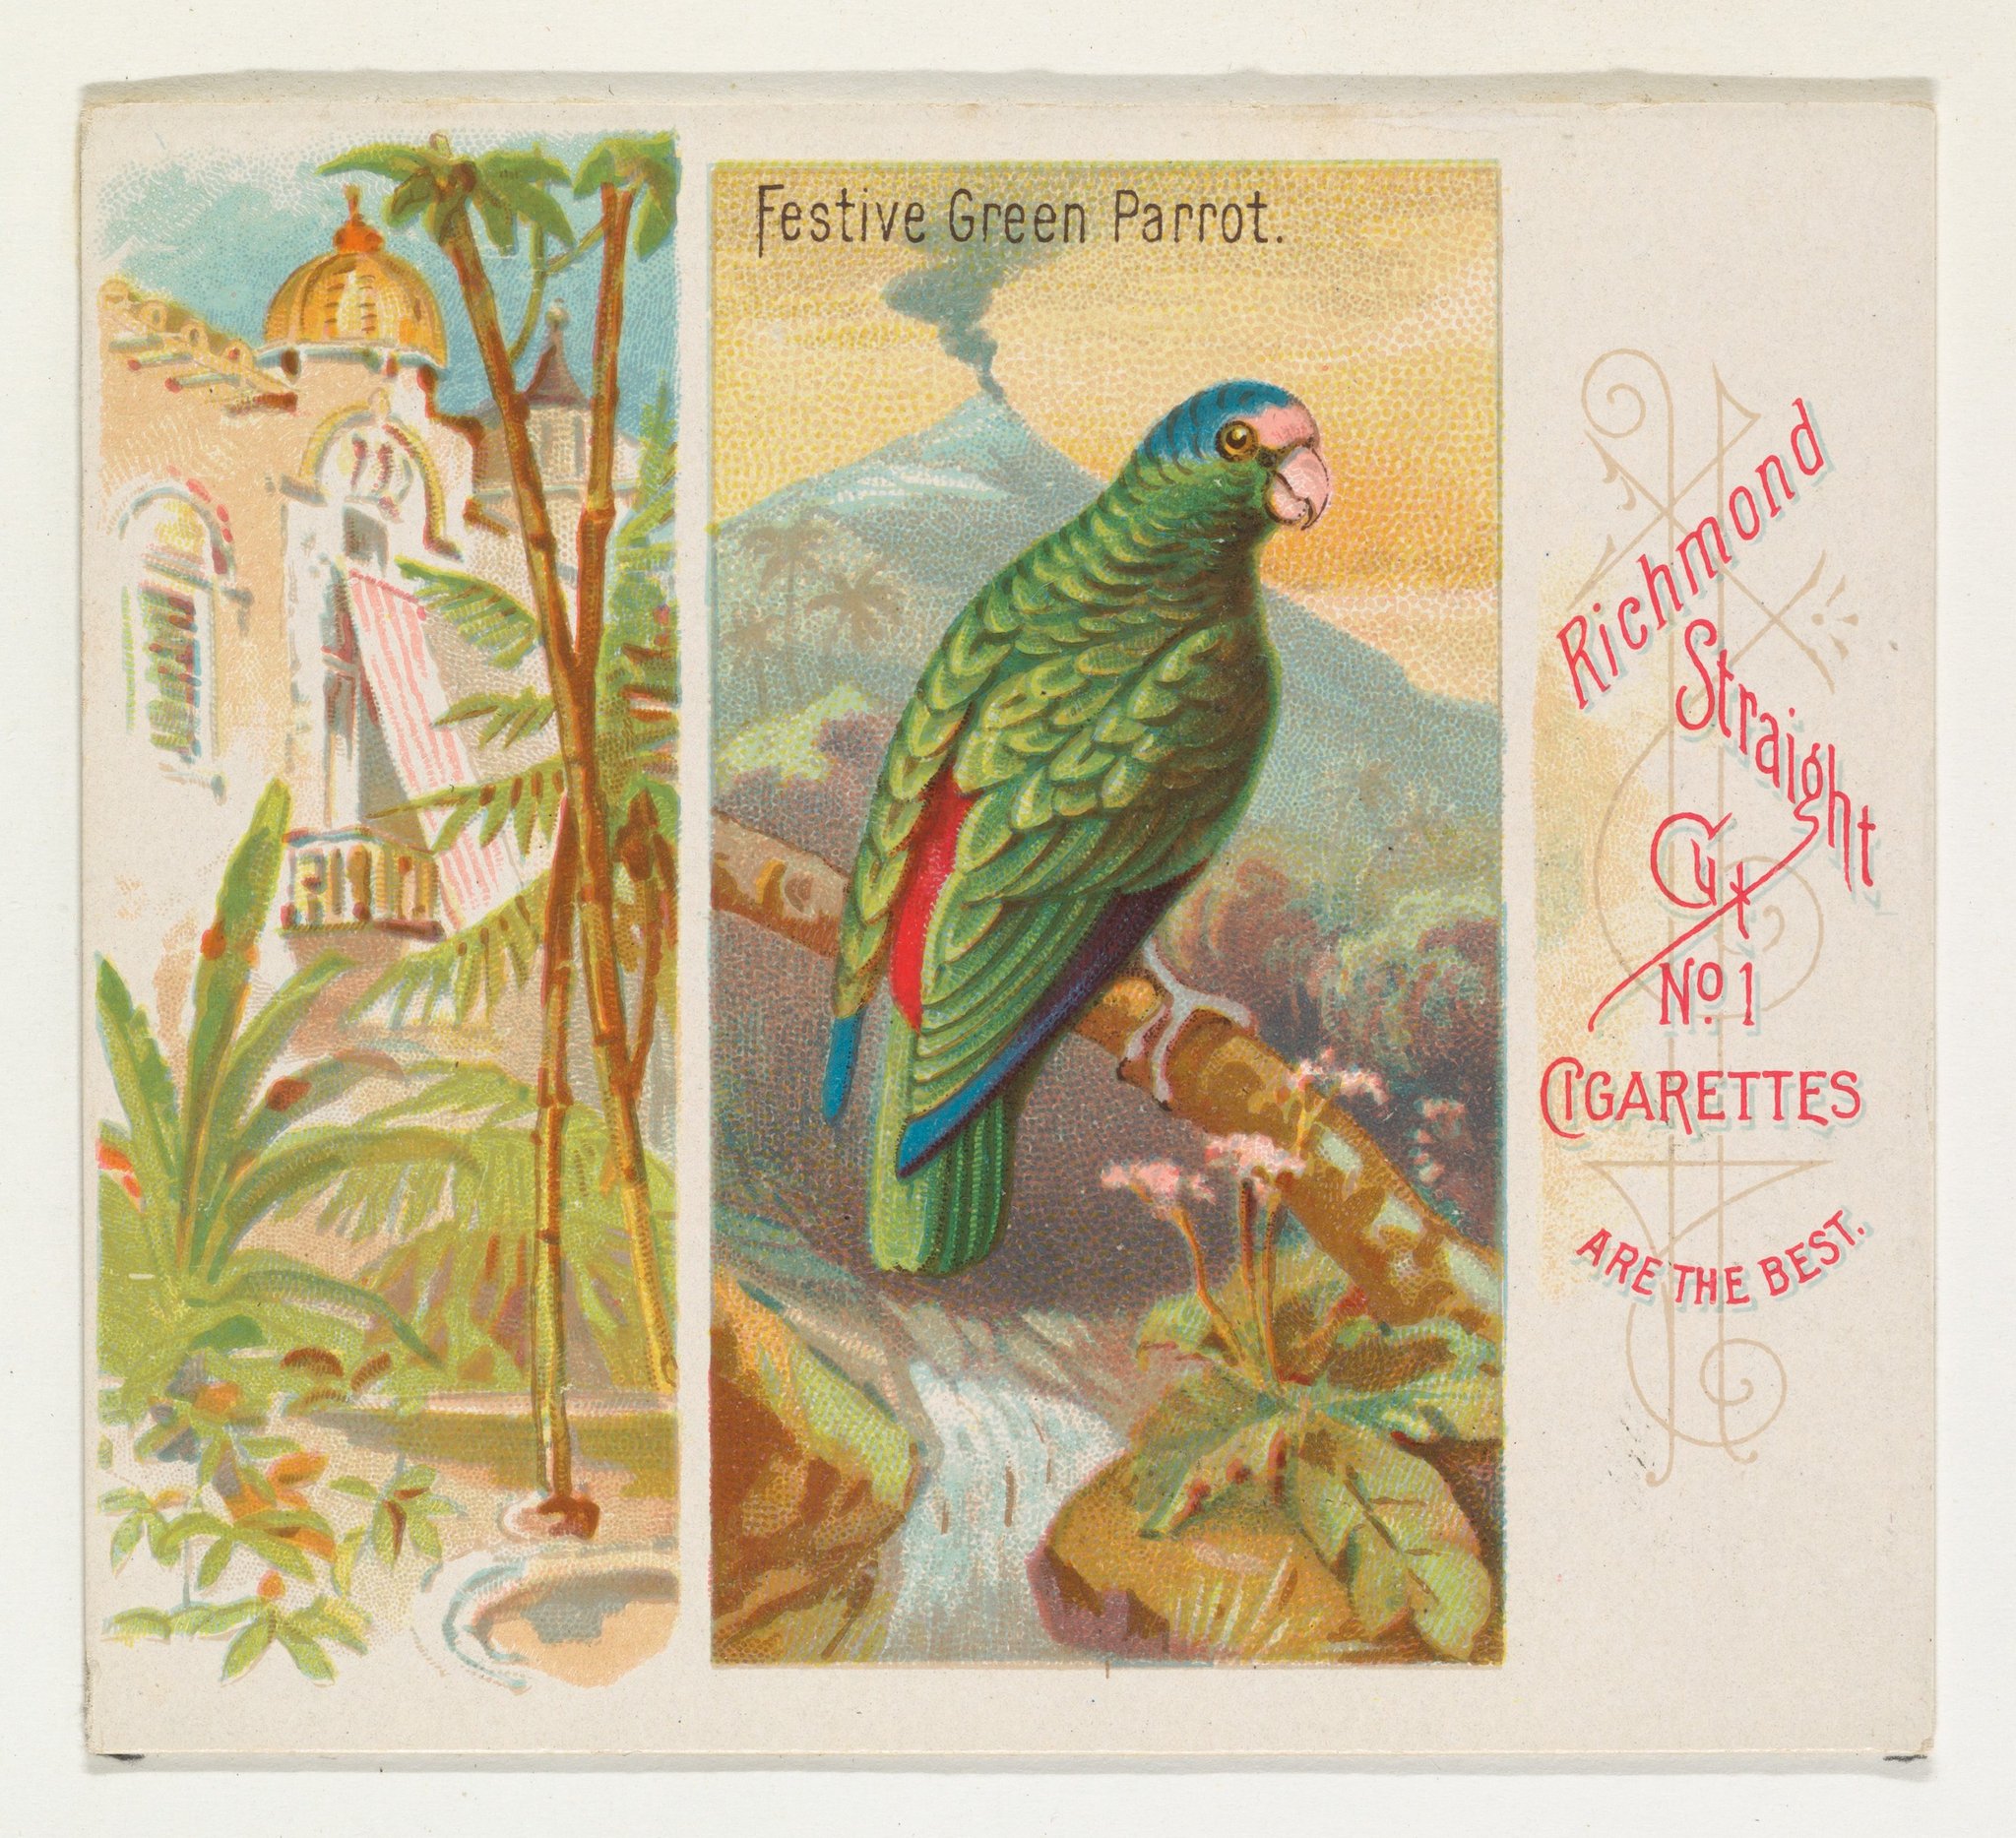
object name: print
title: Festive Green Parrot, from Birds of the Tropics series (N38) for Allen & Ginter Cigarettes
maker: allen & ginter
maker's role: publisher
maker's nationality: american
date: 1889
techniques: color lithograph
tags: parrots